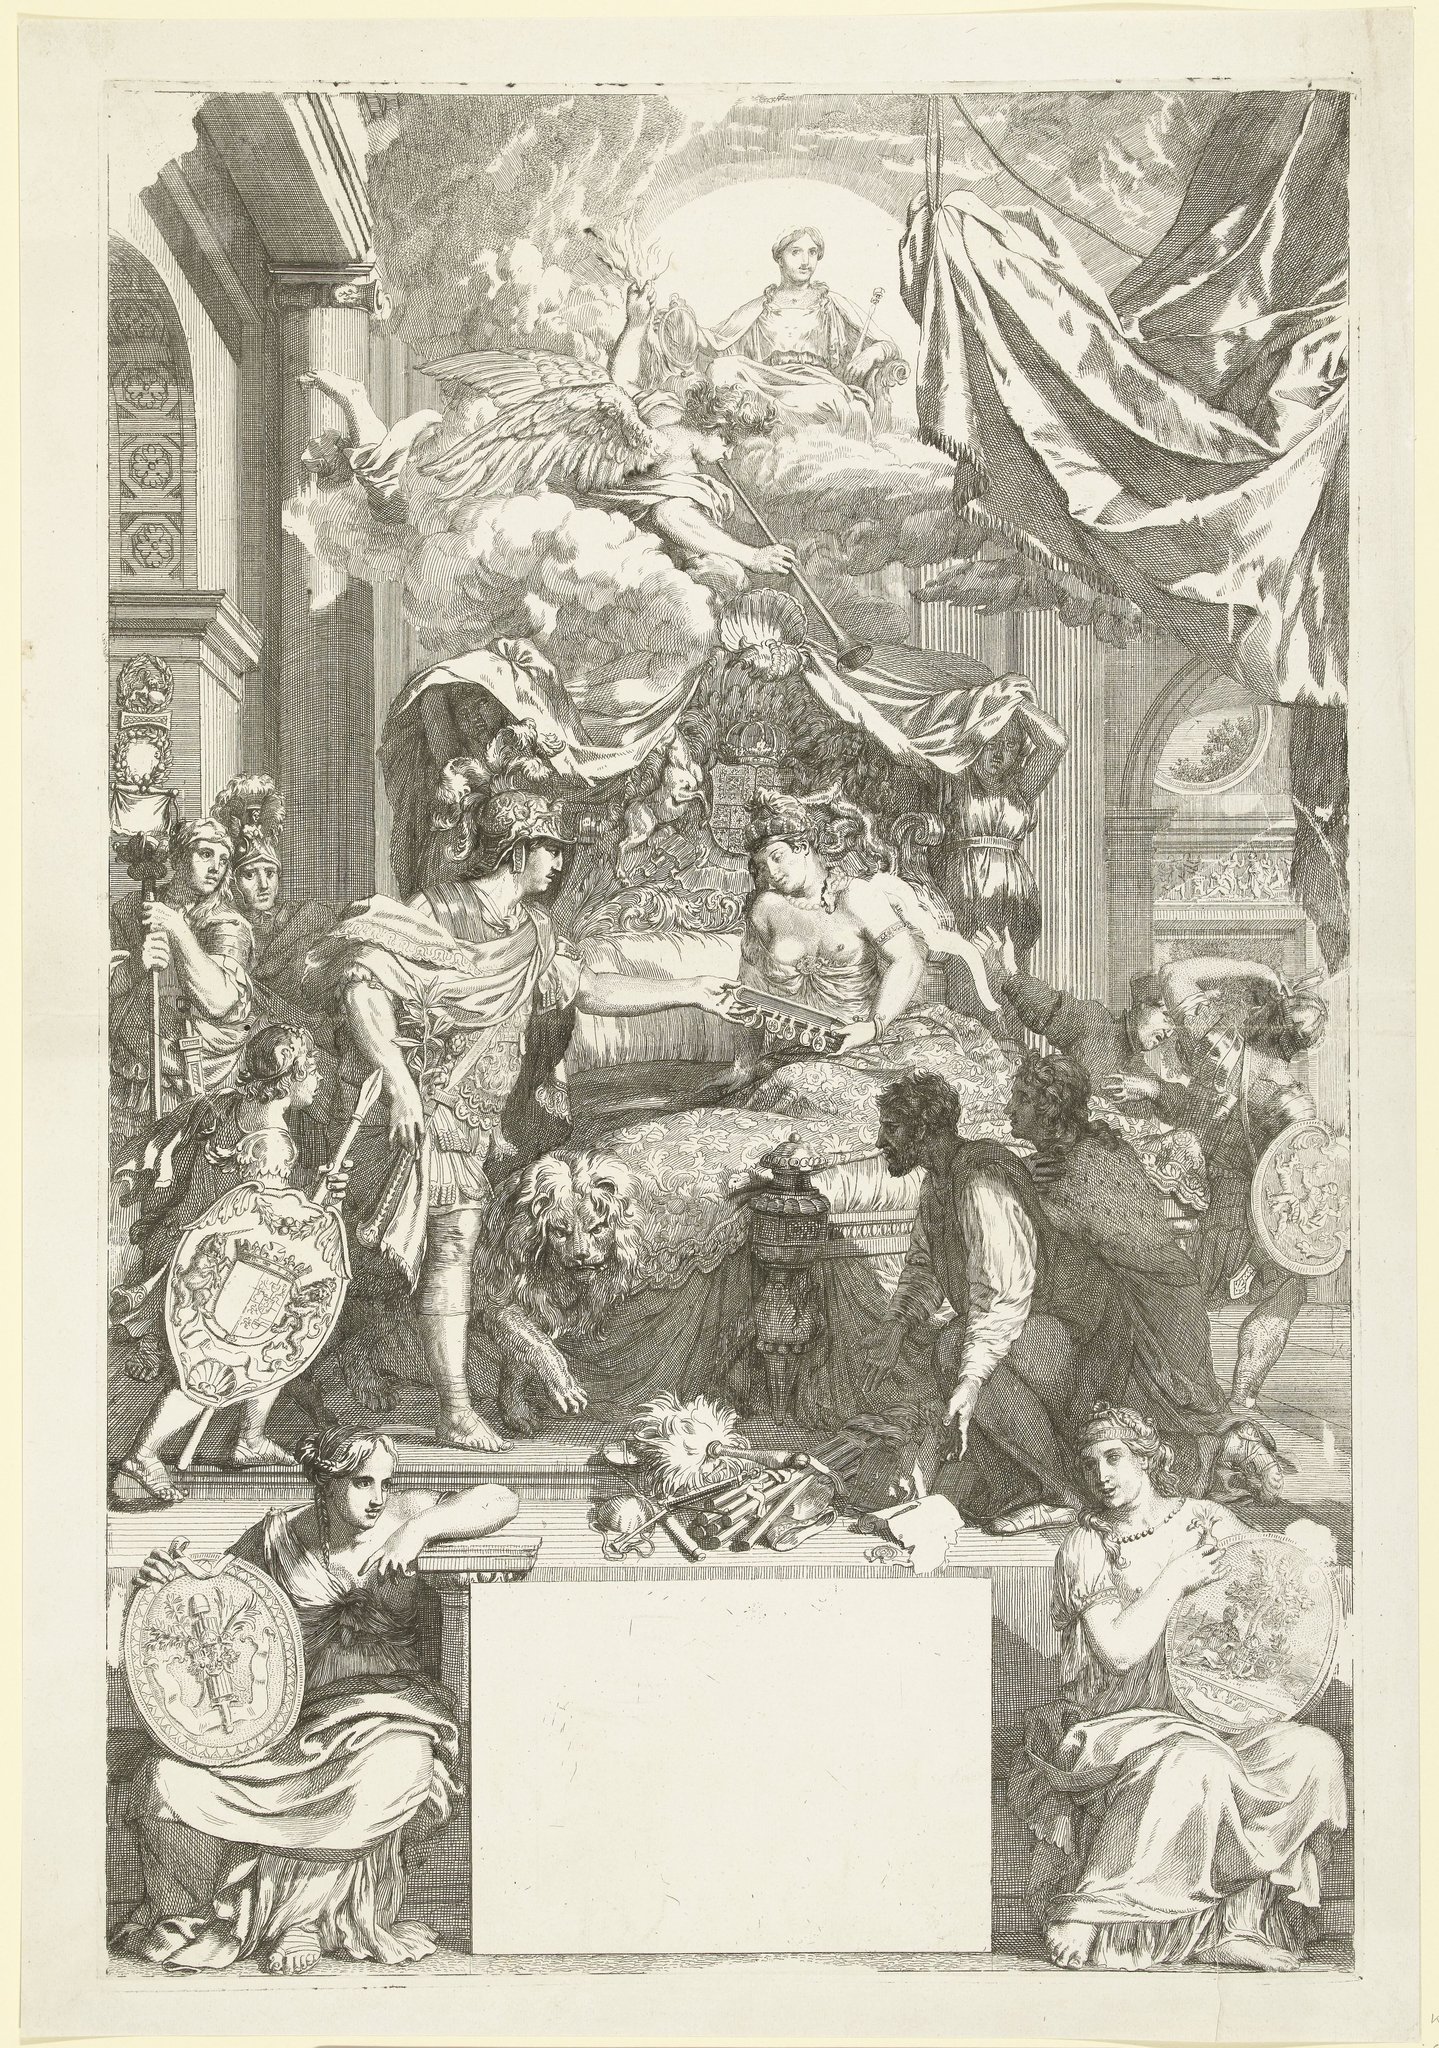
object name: print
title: Allegorie op het herstel van de ware godsdienst in Engeland met de komst van de prins van Oranje, 1688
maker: gerard de lairesse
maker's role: draughtsman, painter, print maker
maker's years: 1641-1711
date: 1688-1689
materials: paper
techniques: printmaking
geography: northern netherlands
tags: the hague, william iii (prince of orange and king of england, scotland, and ireland), personifications of countries, nations, states, districts, etc., truth; 'verità' (ripa), england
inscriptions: collector's mark: Lugt 240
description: Allegorie op het herstel van de ware godsdienst in Engeland met de komst van de prins van Oranje, 1688. Allegorie waarin een romeinse veldheer, Willem III, vergezeld van de Hollandse Leeuw een verzegelde bijbel overhandigt aan de Engelse Maagd, door haar heer verlaten liggend in bed. Aan het voeteneind knielen de Engelse lord en burger. In de lucht de engel van de wraak Gods met bliksemschichten en bazuin en de tronende Waarheid. Op de voorgrond twee vrouwenfiguren zittend aan weerszijden van een fries met een voorstelling van Hercules gekroond. Spiegelbeeldige tegenafdruk.